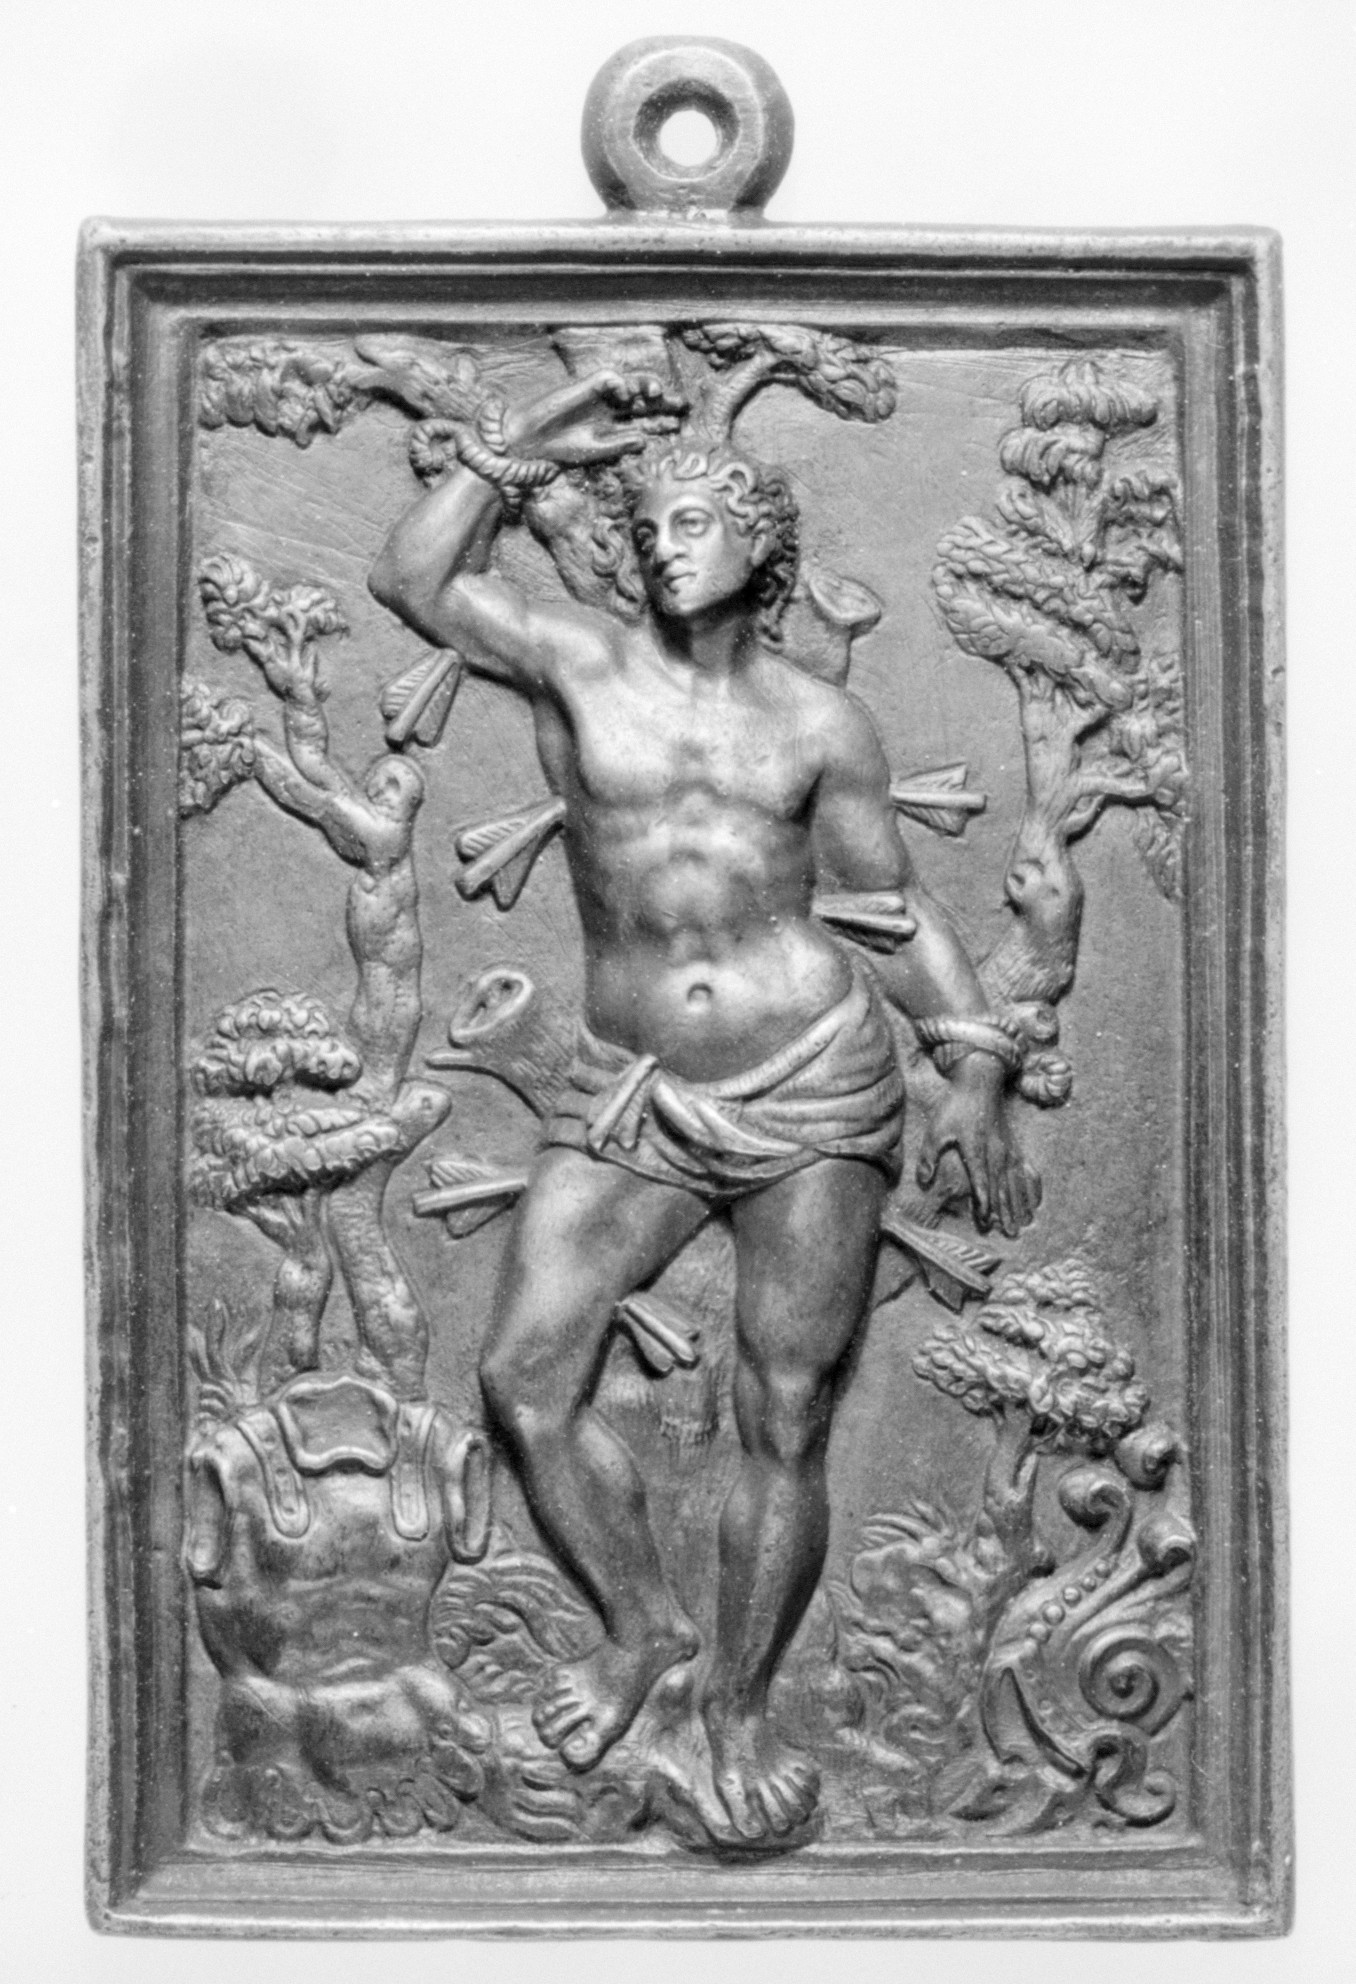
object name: plaquette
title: Martyrdom of St. Sebastian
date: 1501-1600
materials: gilt bronze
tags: suffering,trees,saints